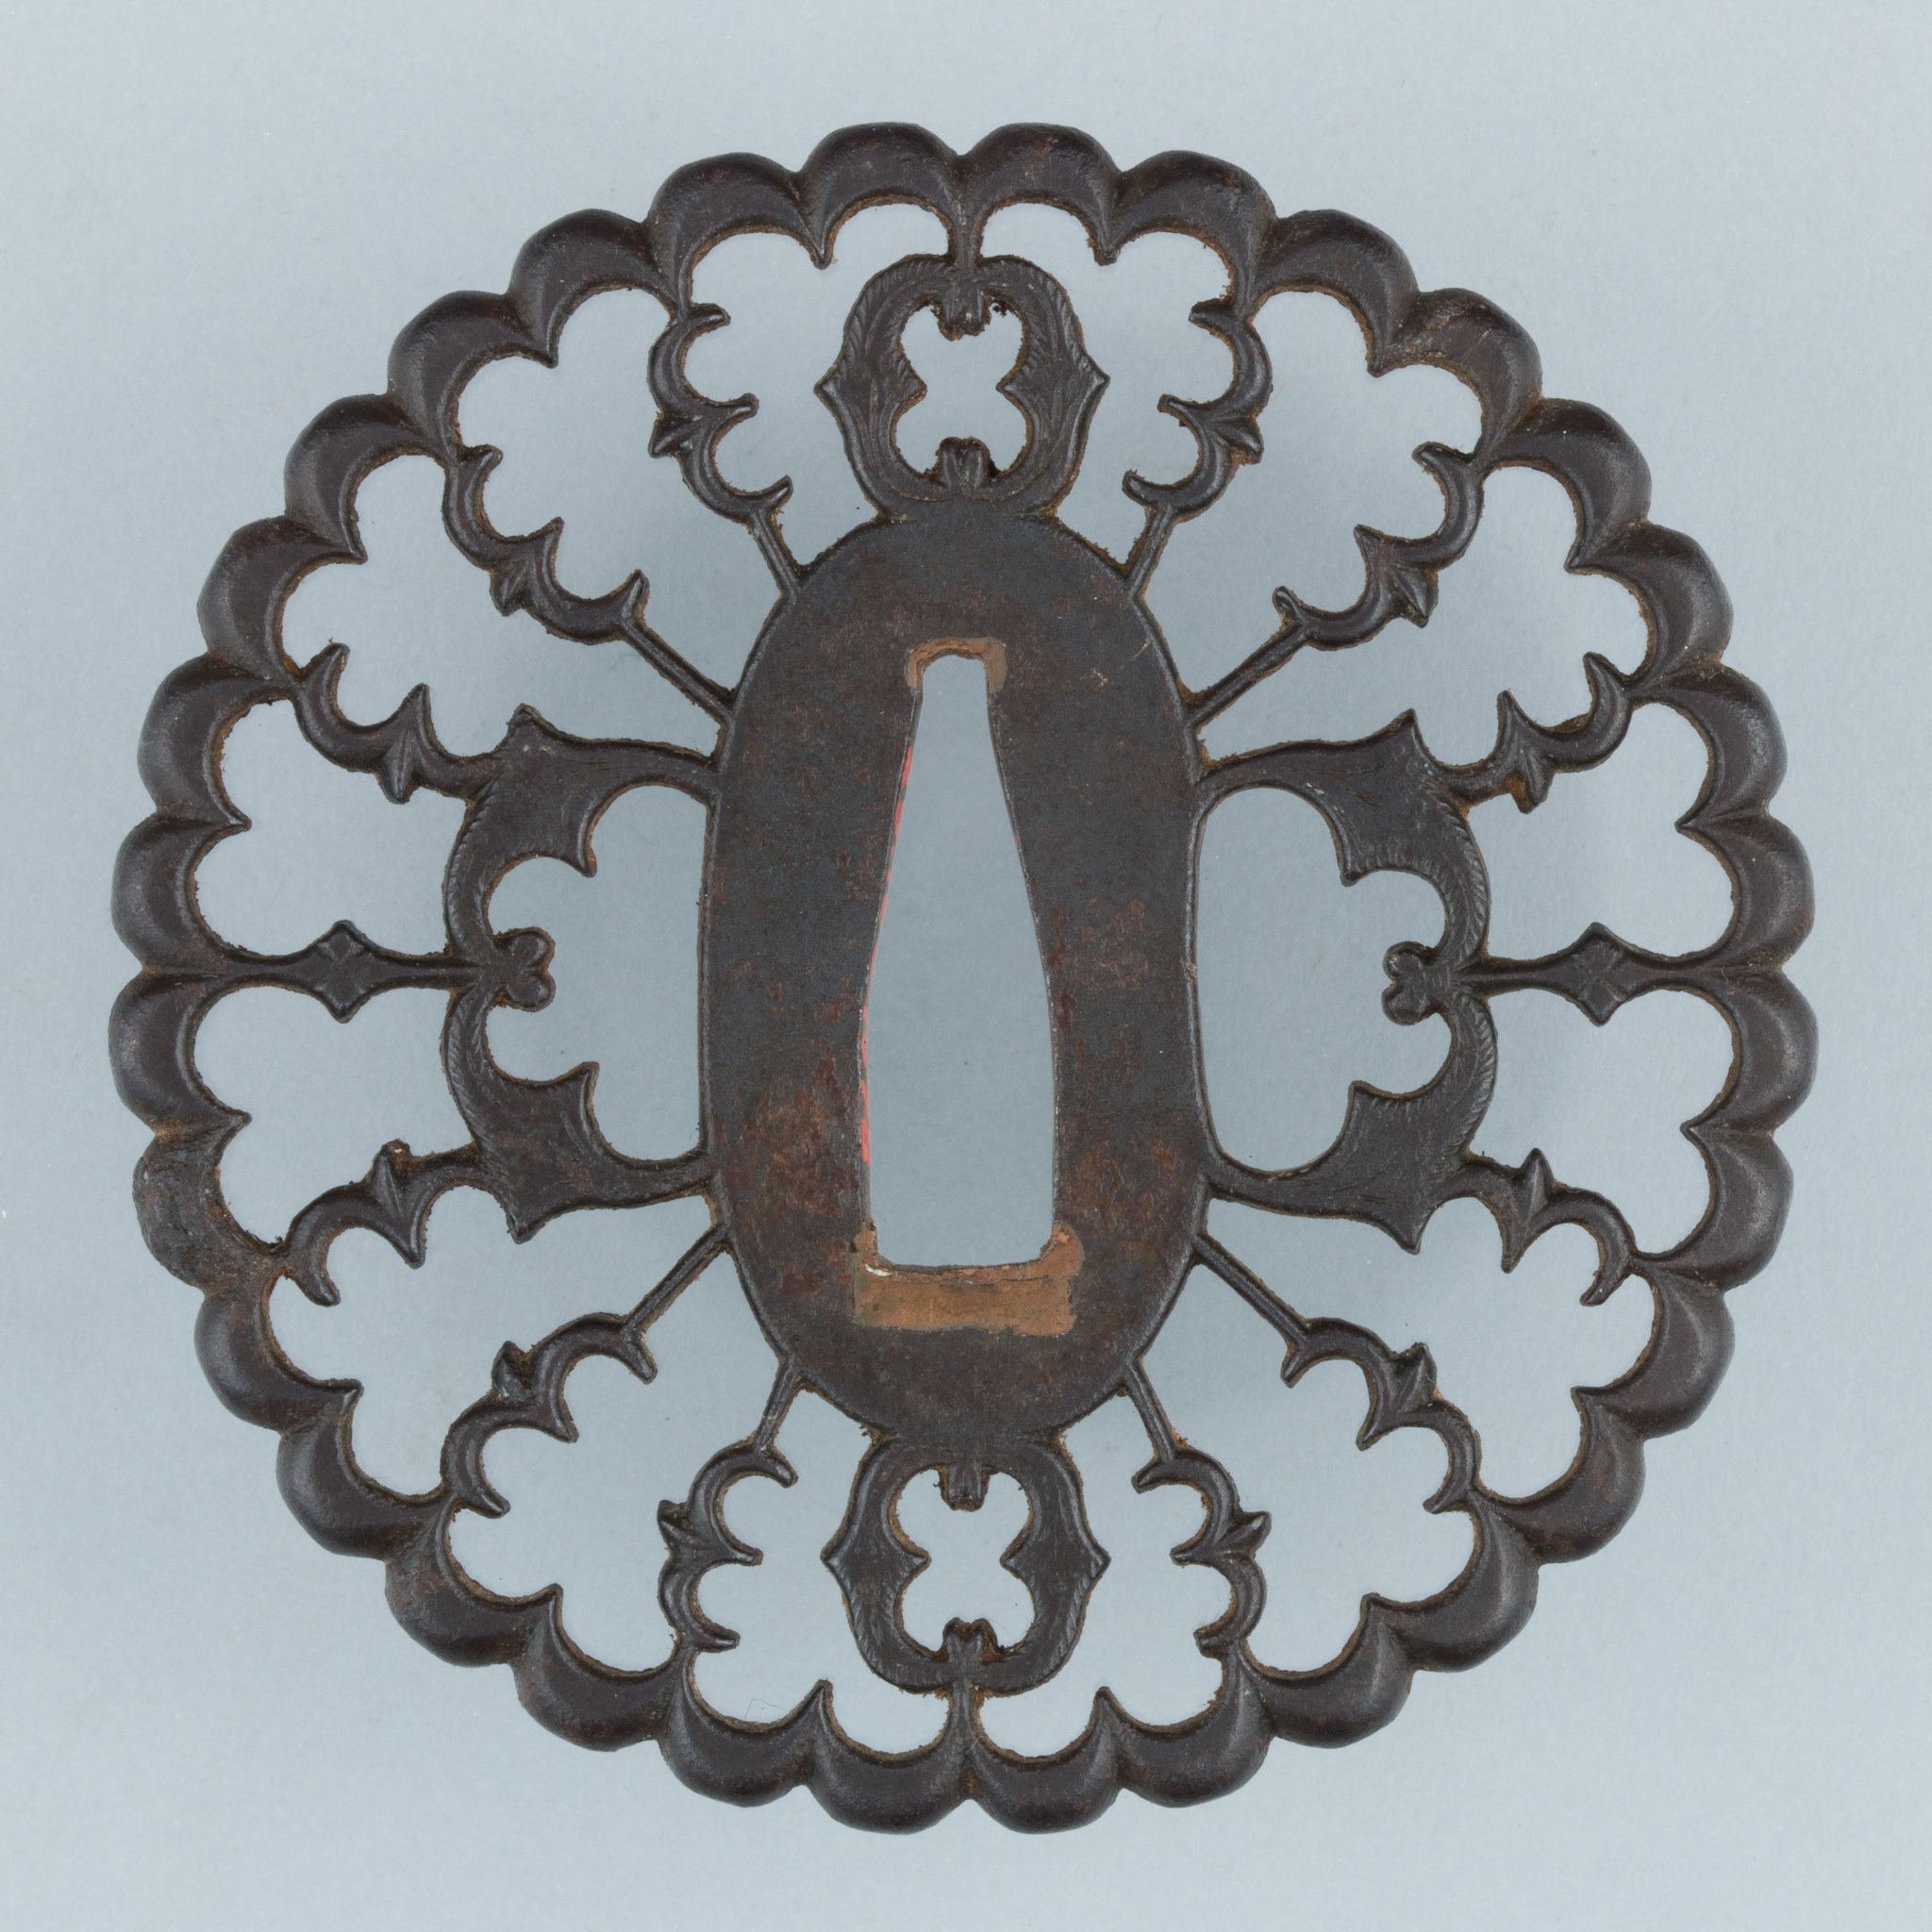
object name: sword guard tsuba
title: Sword Guard (Tsuba)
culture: japanese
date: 1615-1868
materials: copper, iron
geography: japan